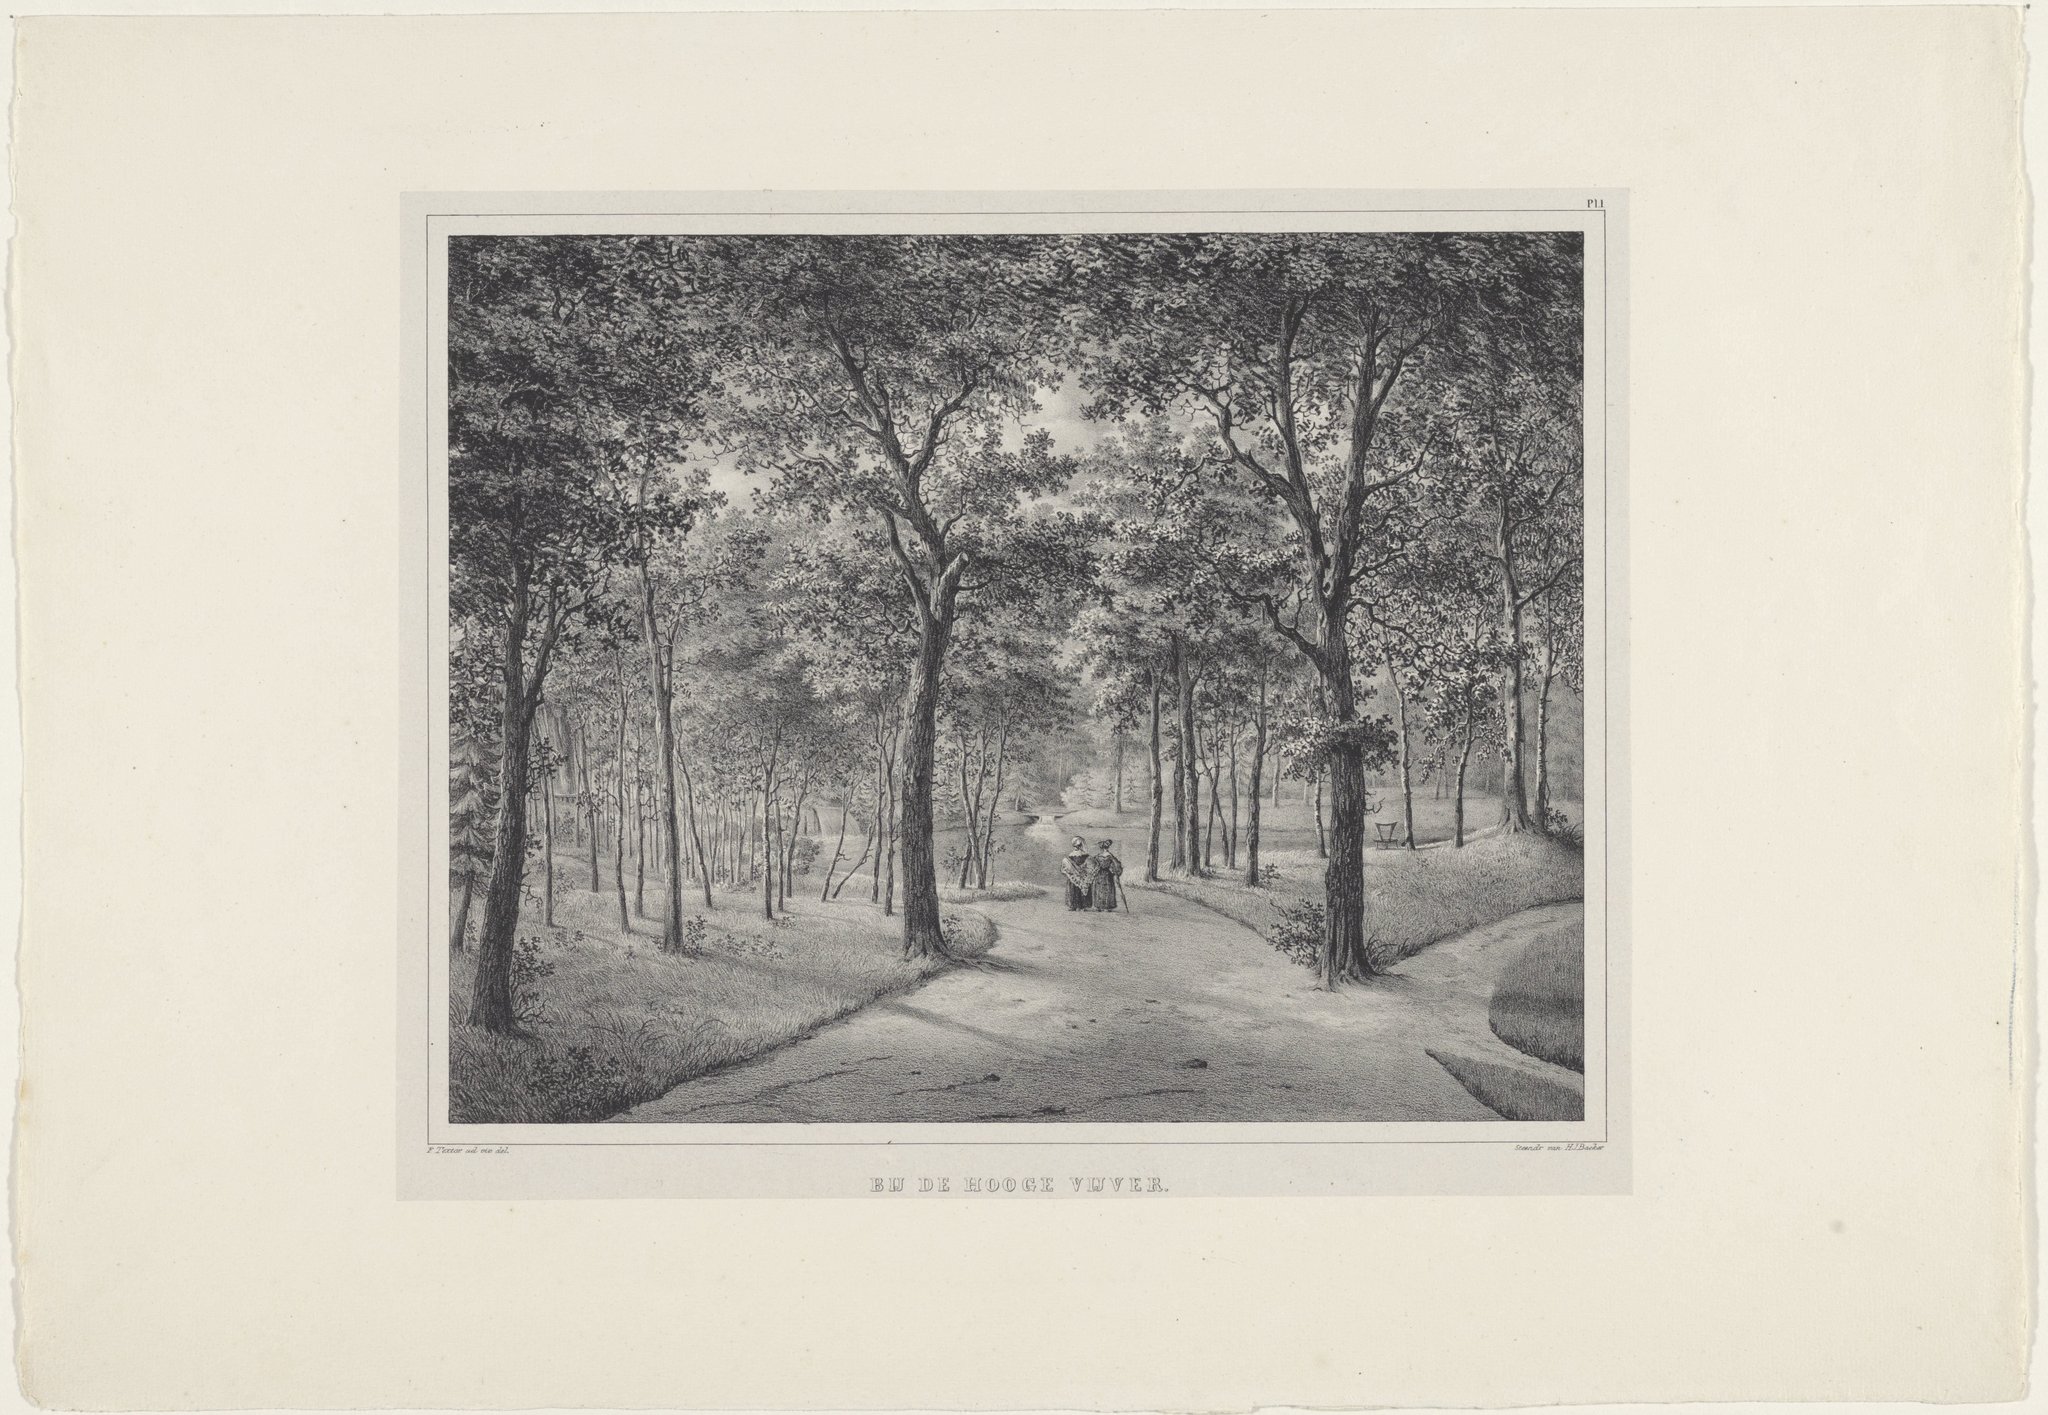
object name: print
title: Gearmde figuren bij de hoge vijver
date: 1822-1845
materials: paper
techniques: lithograph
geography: the hague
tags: arm in arm (friends), waterfall, garden pond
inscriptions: collector's mark: Lugt 2228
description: Twee vrouwen lopen gearmd over een pad richting de vijver. In de verte twee kleine watervallen. Genummerd rechtsboven: Pl. 1.